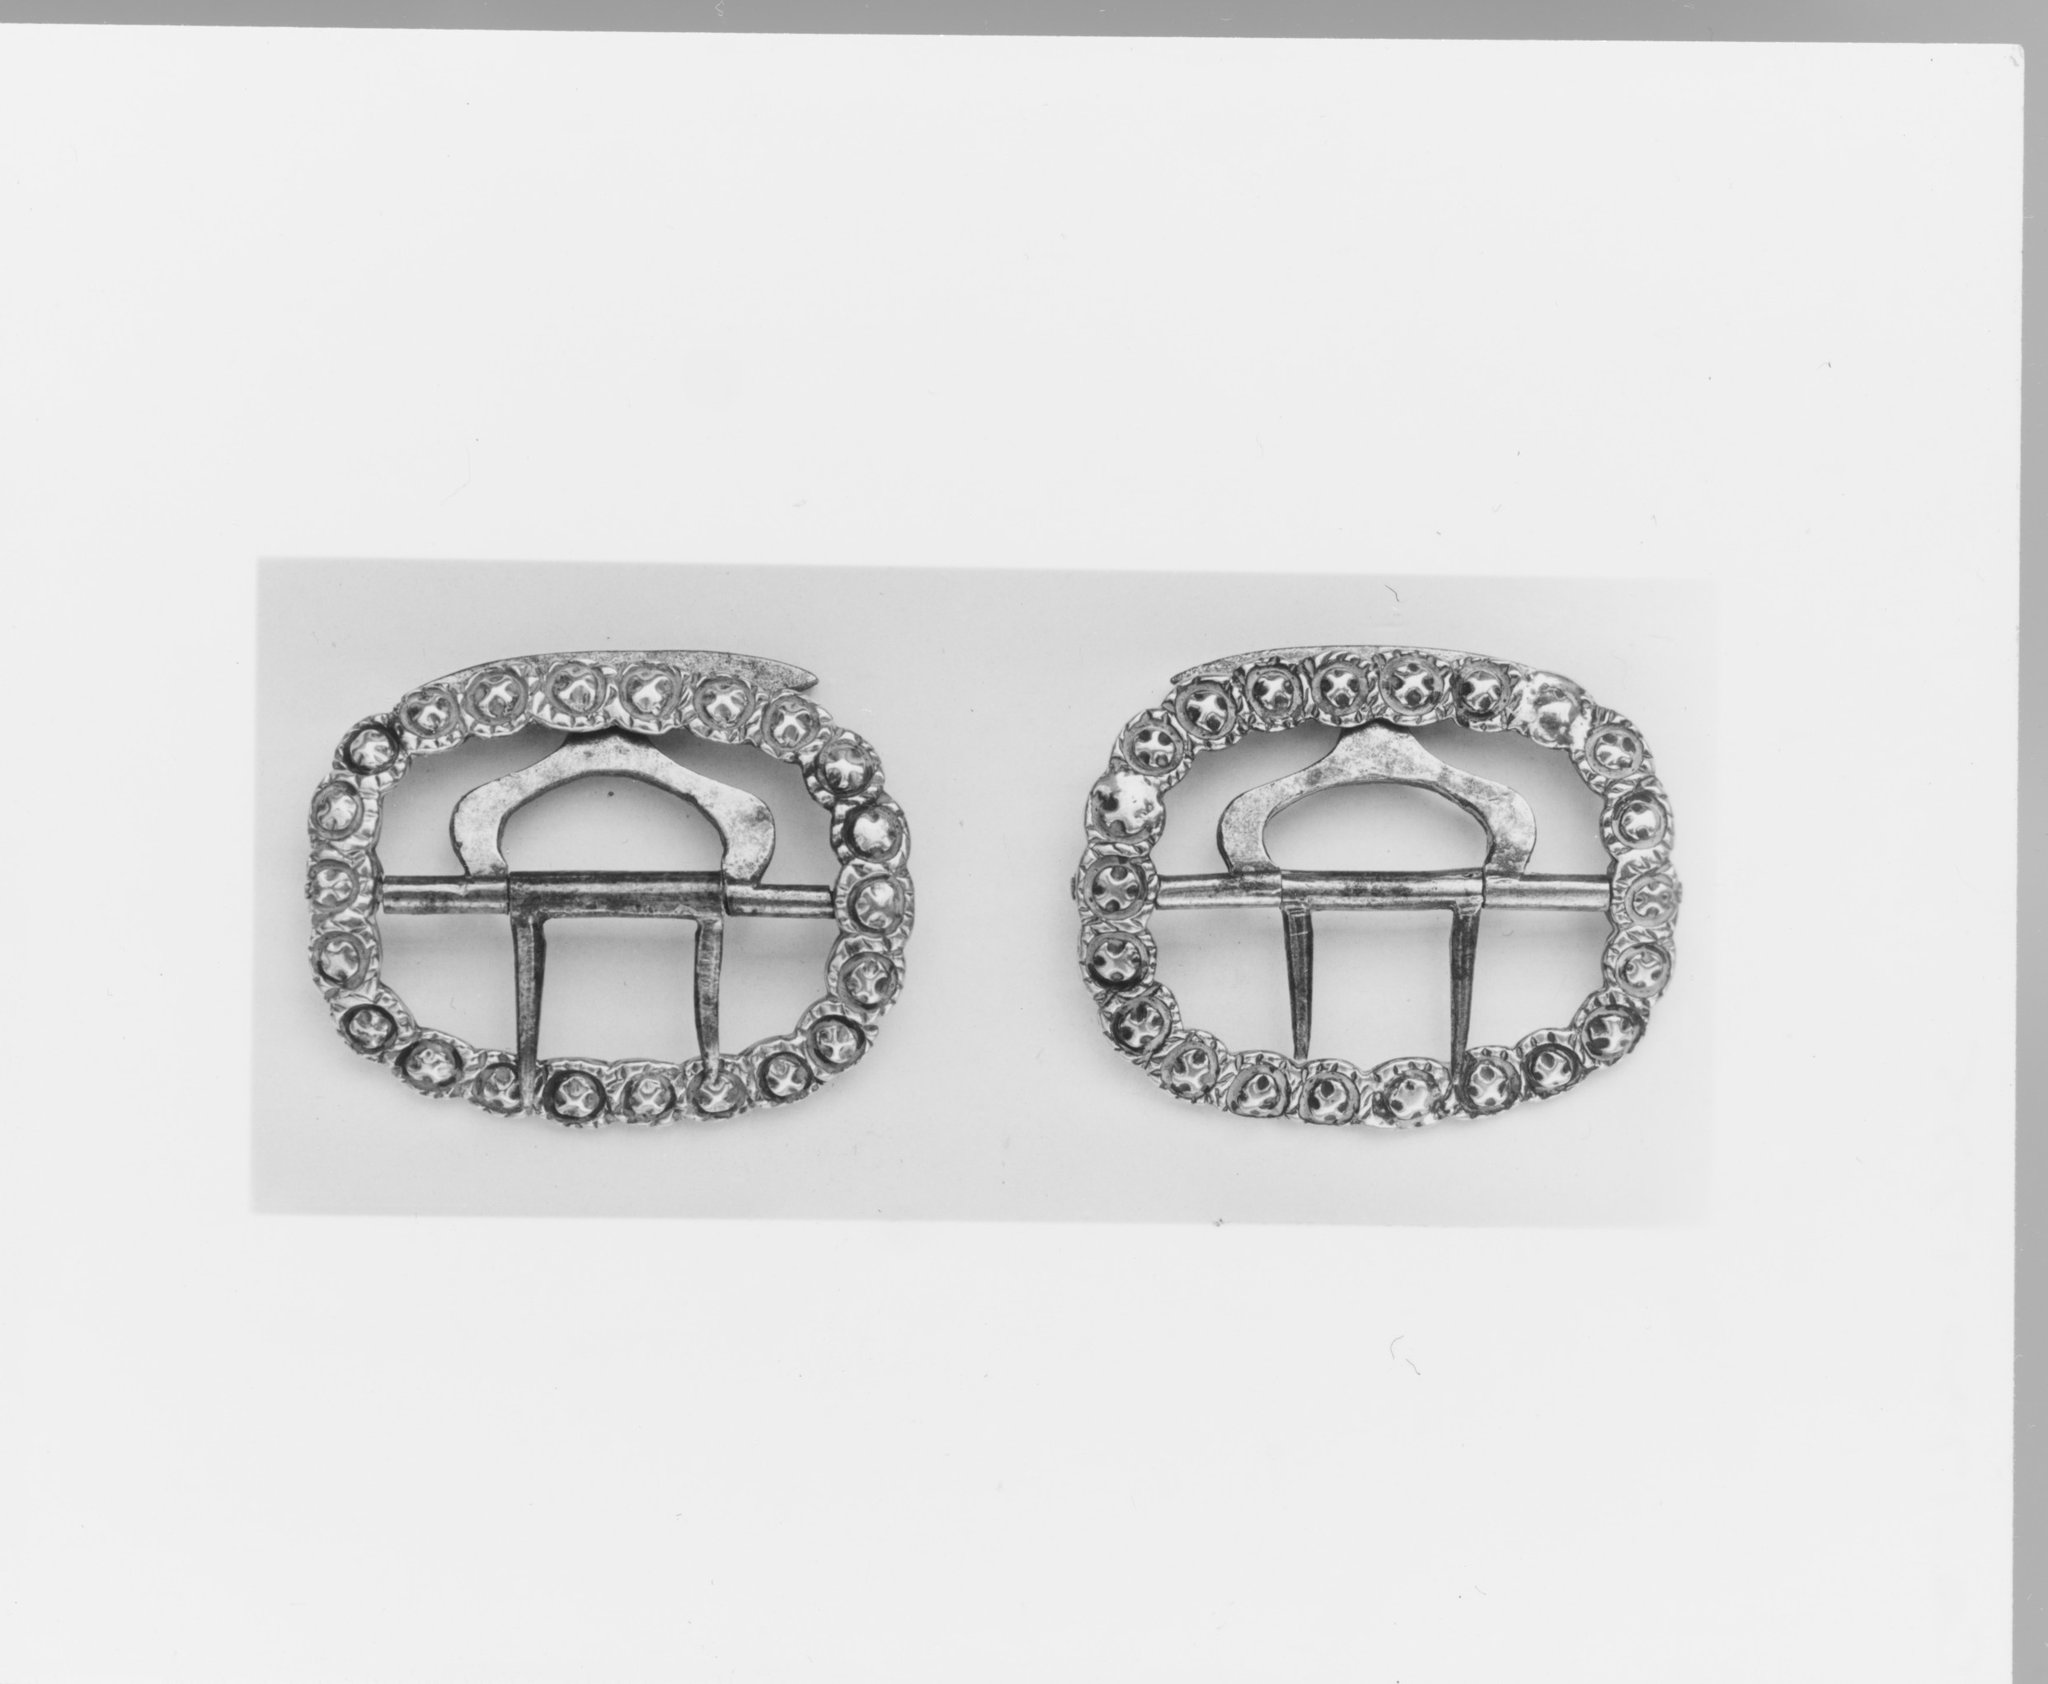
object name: buckle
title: Knee Buckle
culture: american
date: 1730-1775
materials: silver